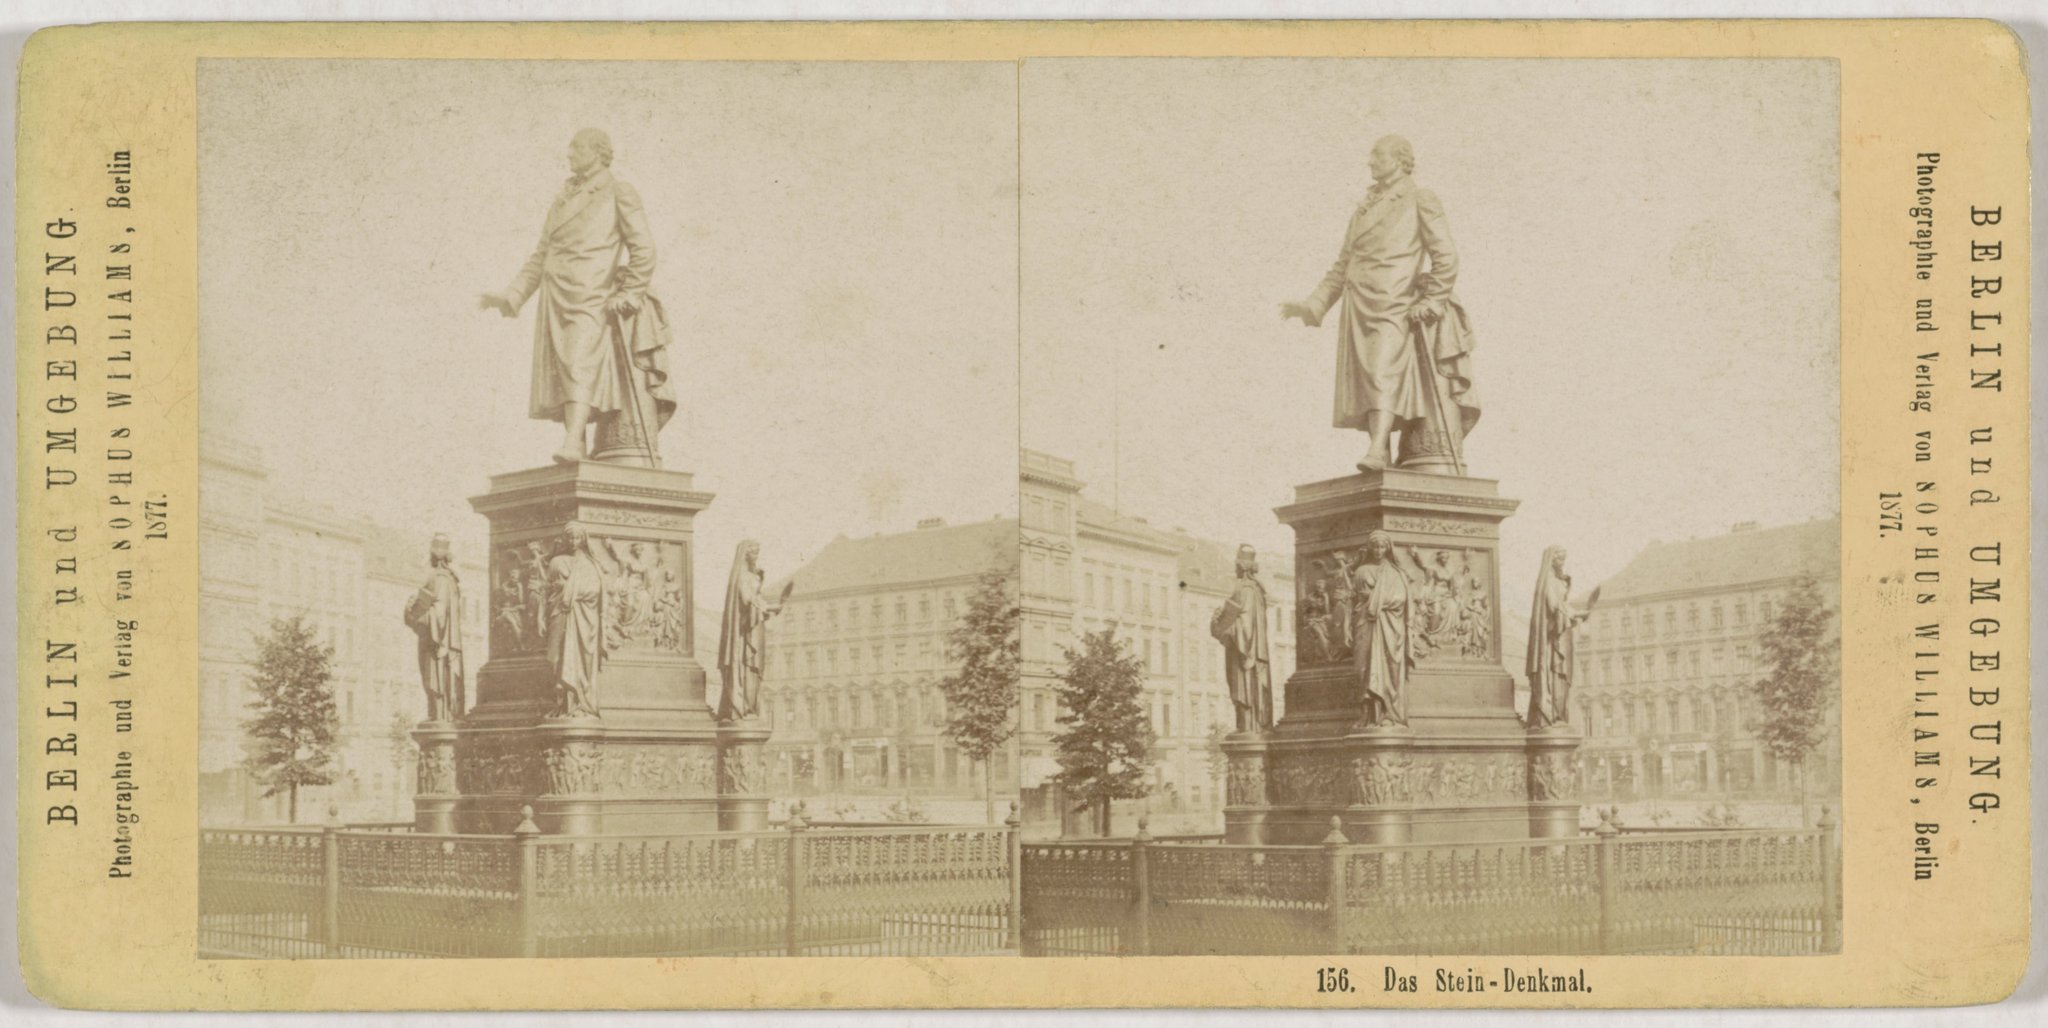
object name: stereograph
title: Berlin und Umgebung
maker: sophus williams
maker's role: publisher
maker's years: 1835-1900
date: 1877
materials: cardboard, paper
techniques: albumen print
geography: berlin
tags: monument, statue